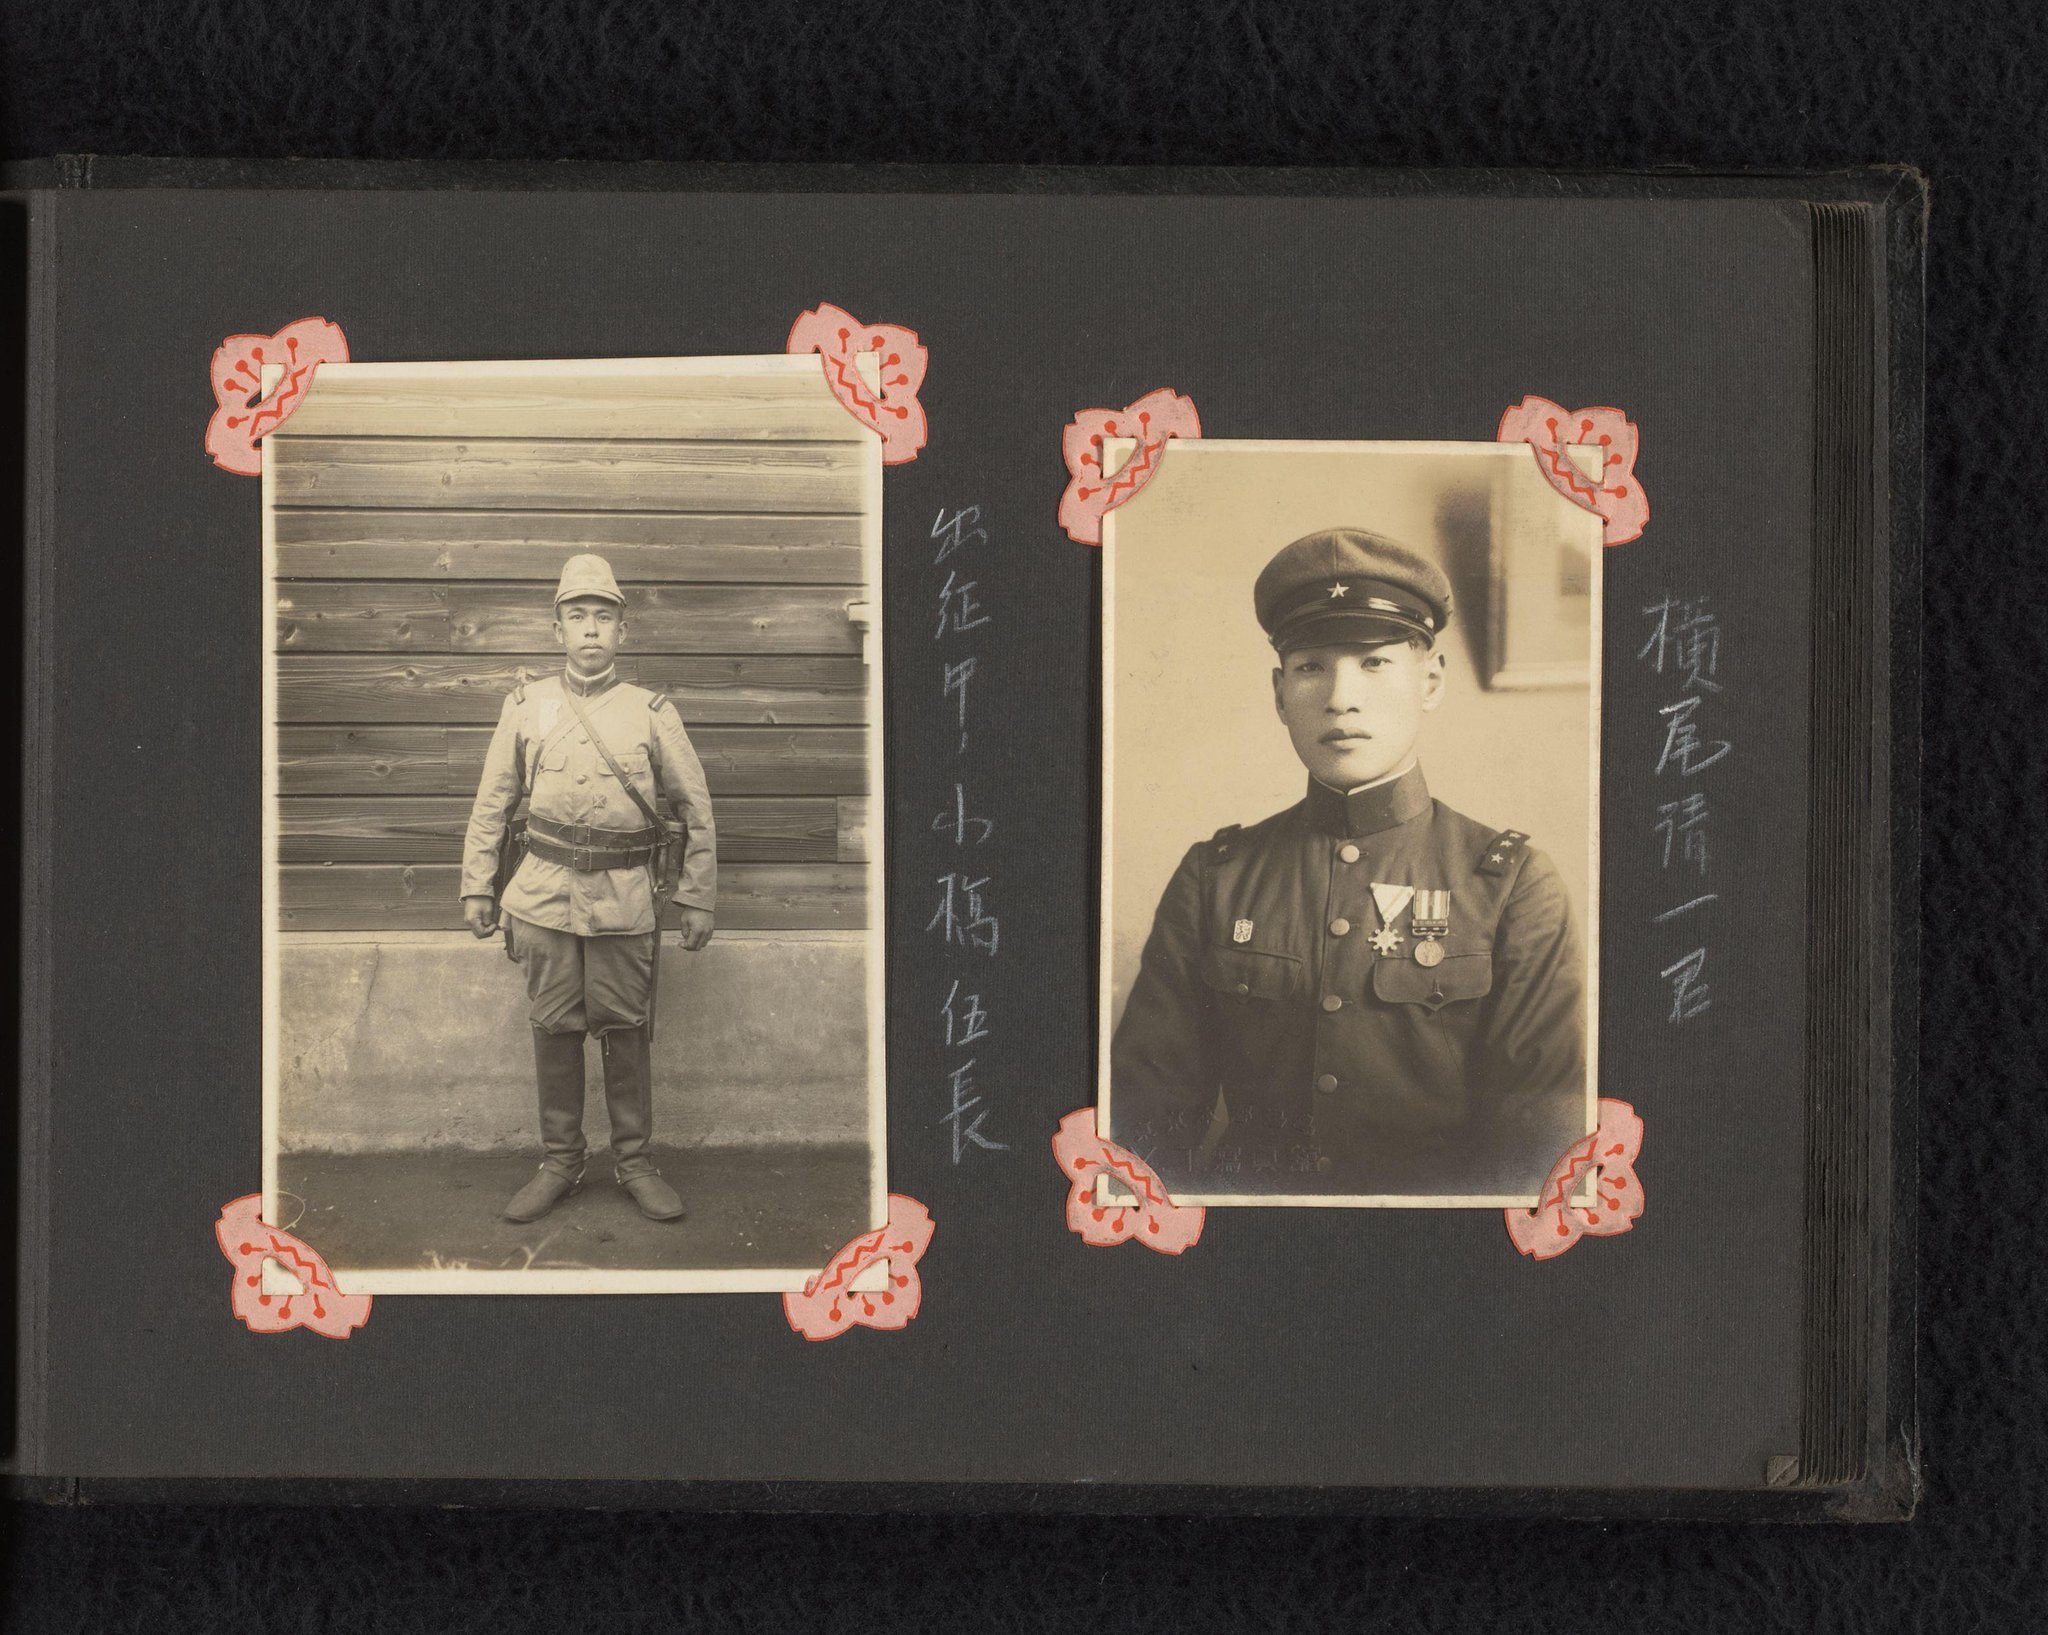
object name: photograph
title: Twee portretten van onbekende Japanse soldaten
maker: Anonymous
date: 1937-1941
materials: paper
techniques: gelatin silver print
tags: anonymous historical person portrayed, the soldier; the soldier's life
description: Deze foto's zijn onderdeel van een album.